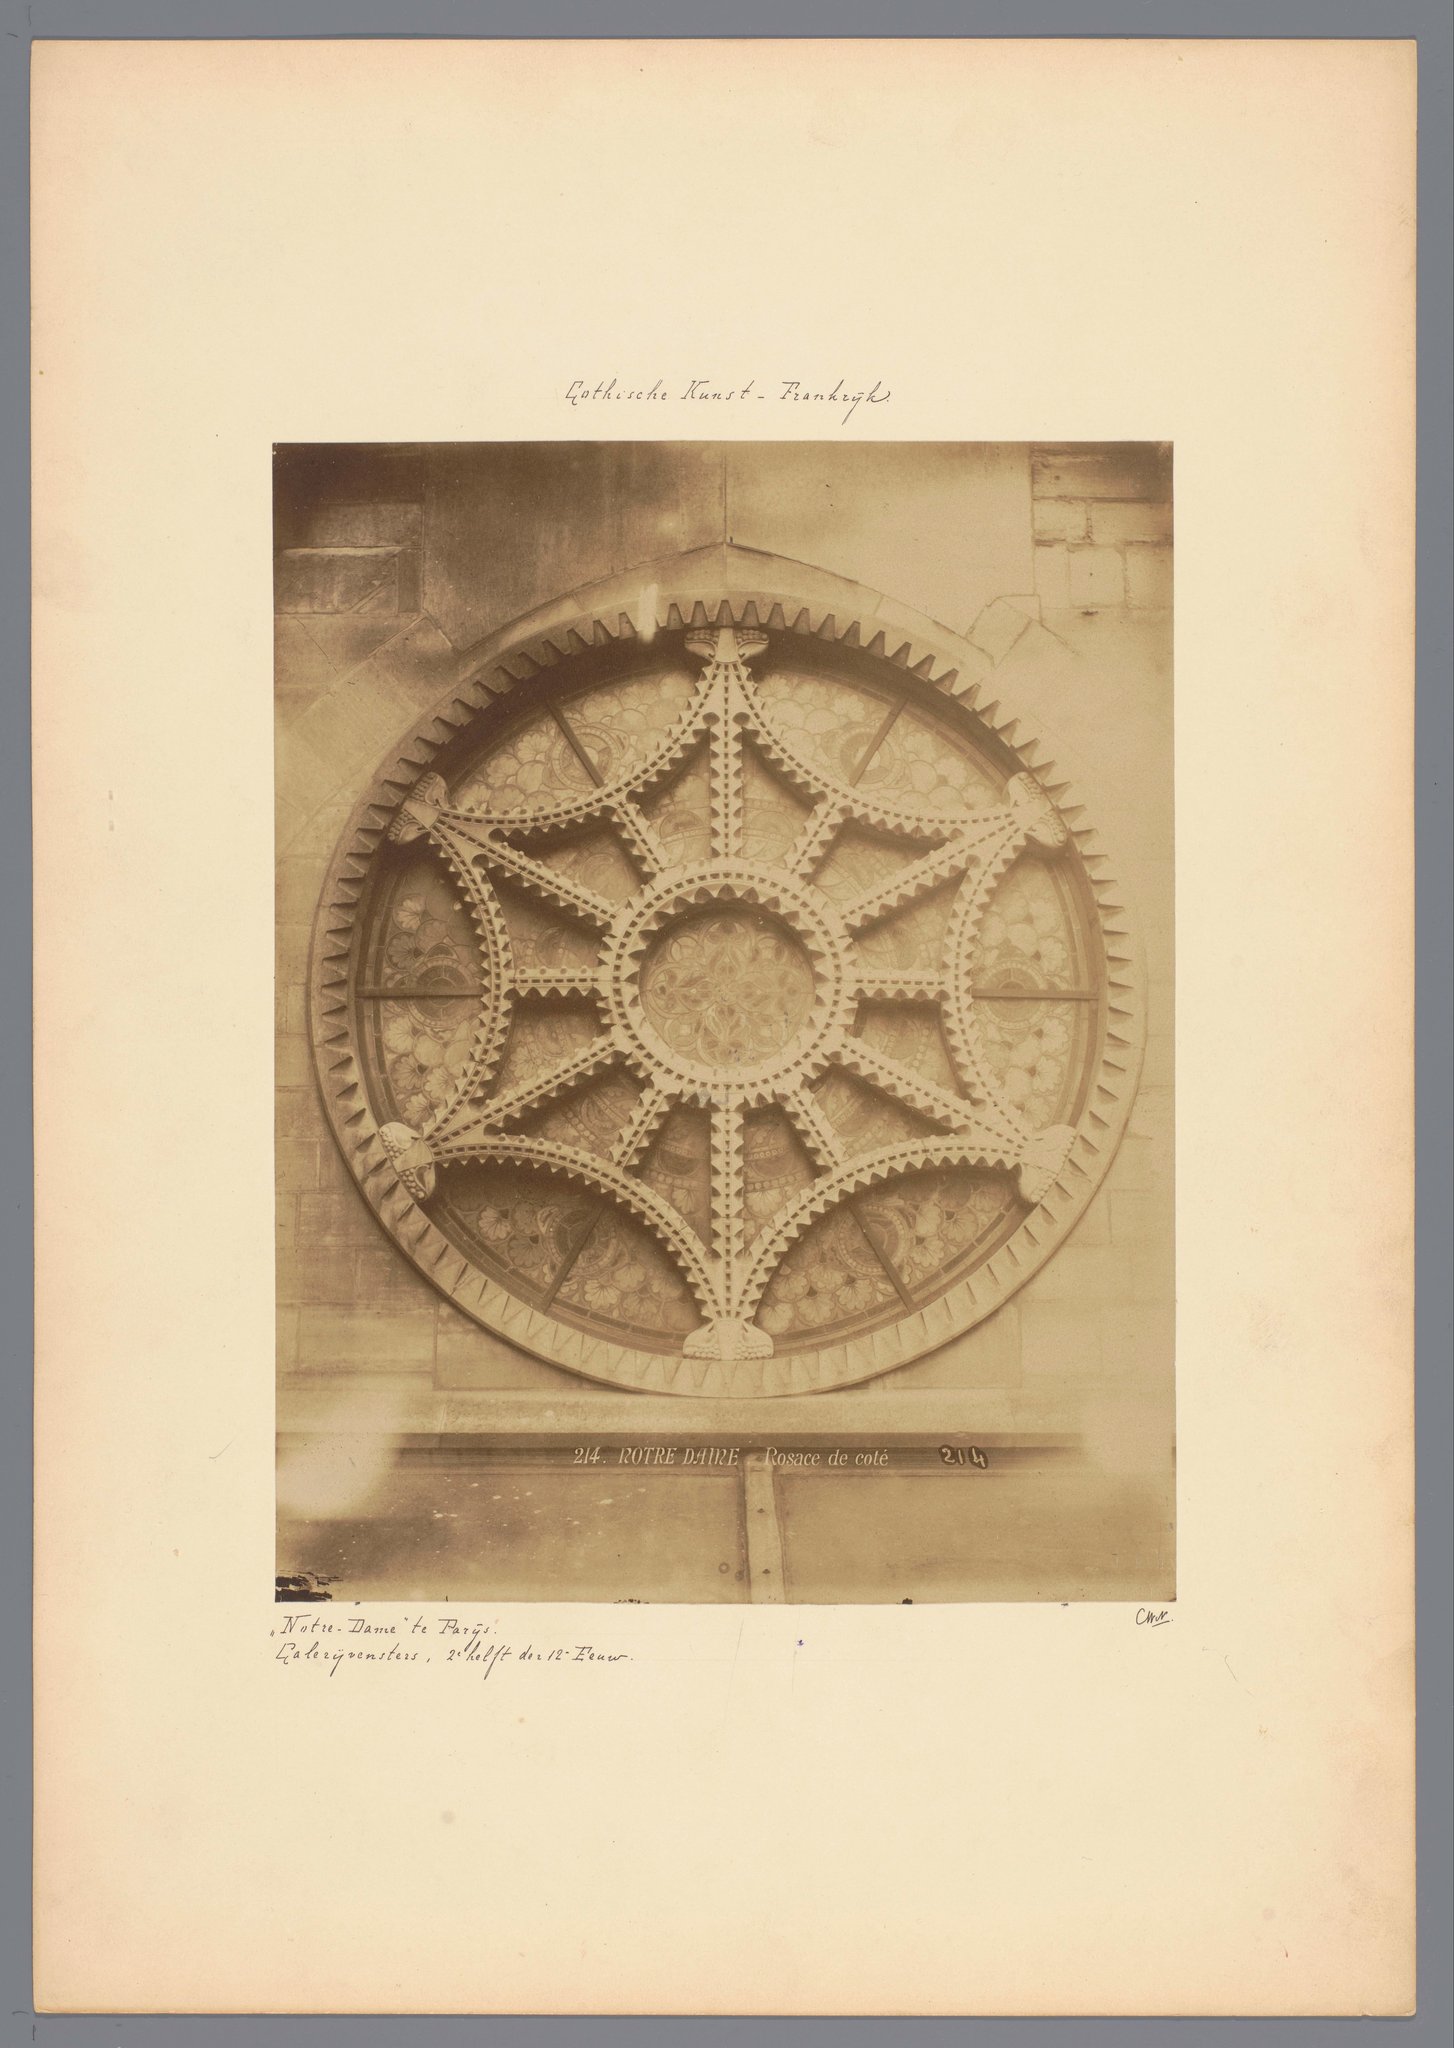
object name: photograph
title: Roosvenster in de Notre-Dame te Parijs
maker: j. kuhn (fotograaf)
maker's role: fotograaf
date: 1875-1900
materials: cardboard, photographic support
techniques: albumen print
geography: notre-dame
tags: church-window, e.g. rose-window, interior of church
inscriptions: collector's mark: ‘KUNSTNIJVERHEIDSCHOOL QUELLINUS AMSTERDAM FRANS HALSSTRAAT 14.’, inscription: ‘CWN.’, name: ‘J. KUHN 220, Rue de Rivoli PARIS’, number: ‘214.’, inscription: ‘Gothische Kunst - Frankrijk. ,,Notre-Dame'' te Parijs. Galerijvensters , 2e helft der 12e Eeuw.’, collector's mark: ‘INSTITUUT VOOR KUNST- NIJVERHEIDSONDERWIJS GABRIËL METSUSTRAAT No. 16. AMSTERDAM’